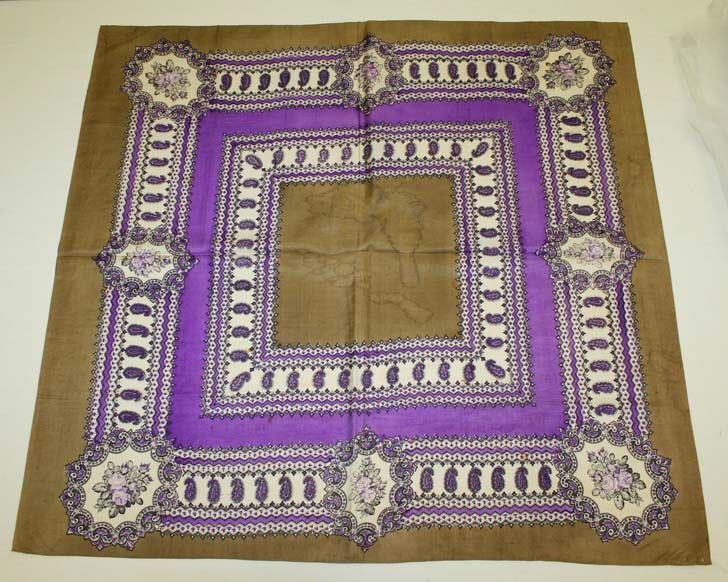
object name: kerchief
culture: spanish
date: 1820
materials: silk